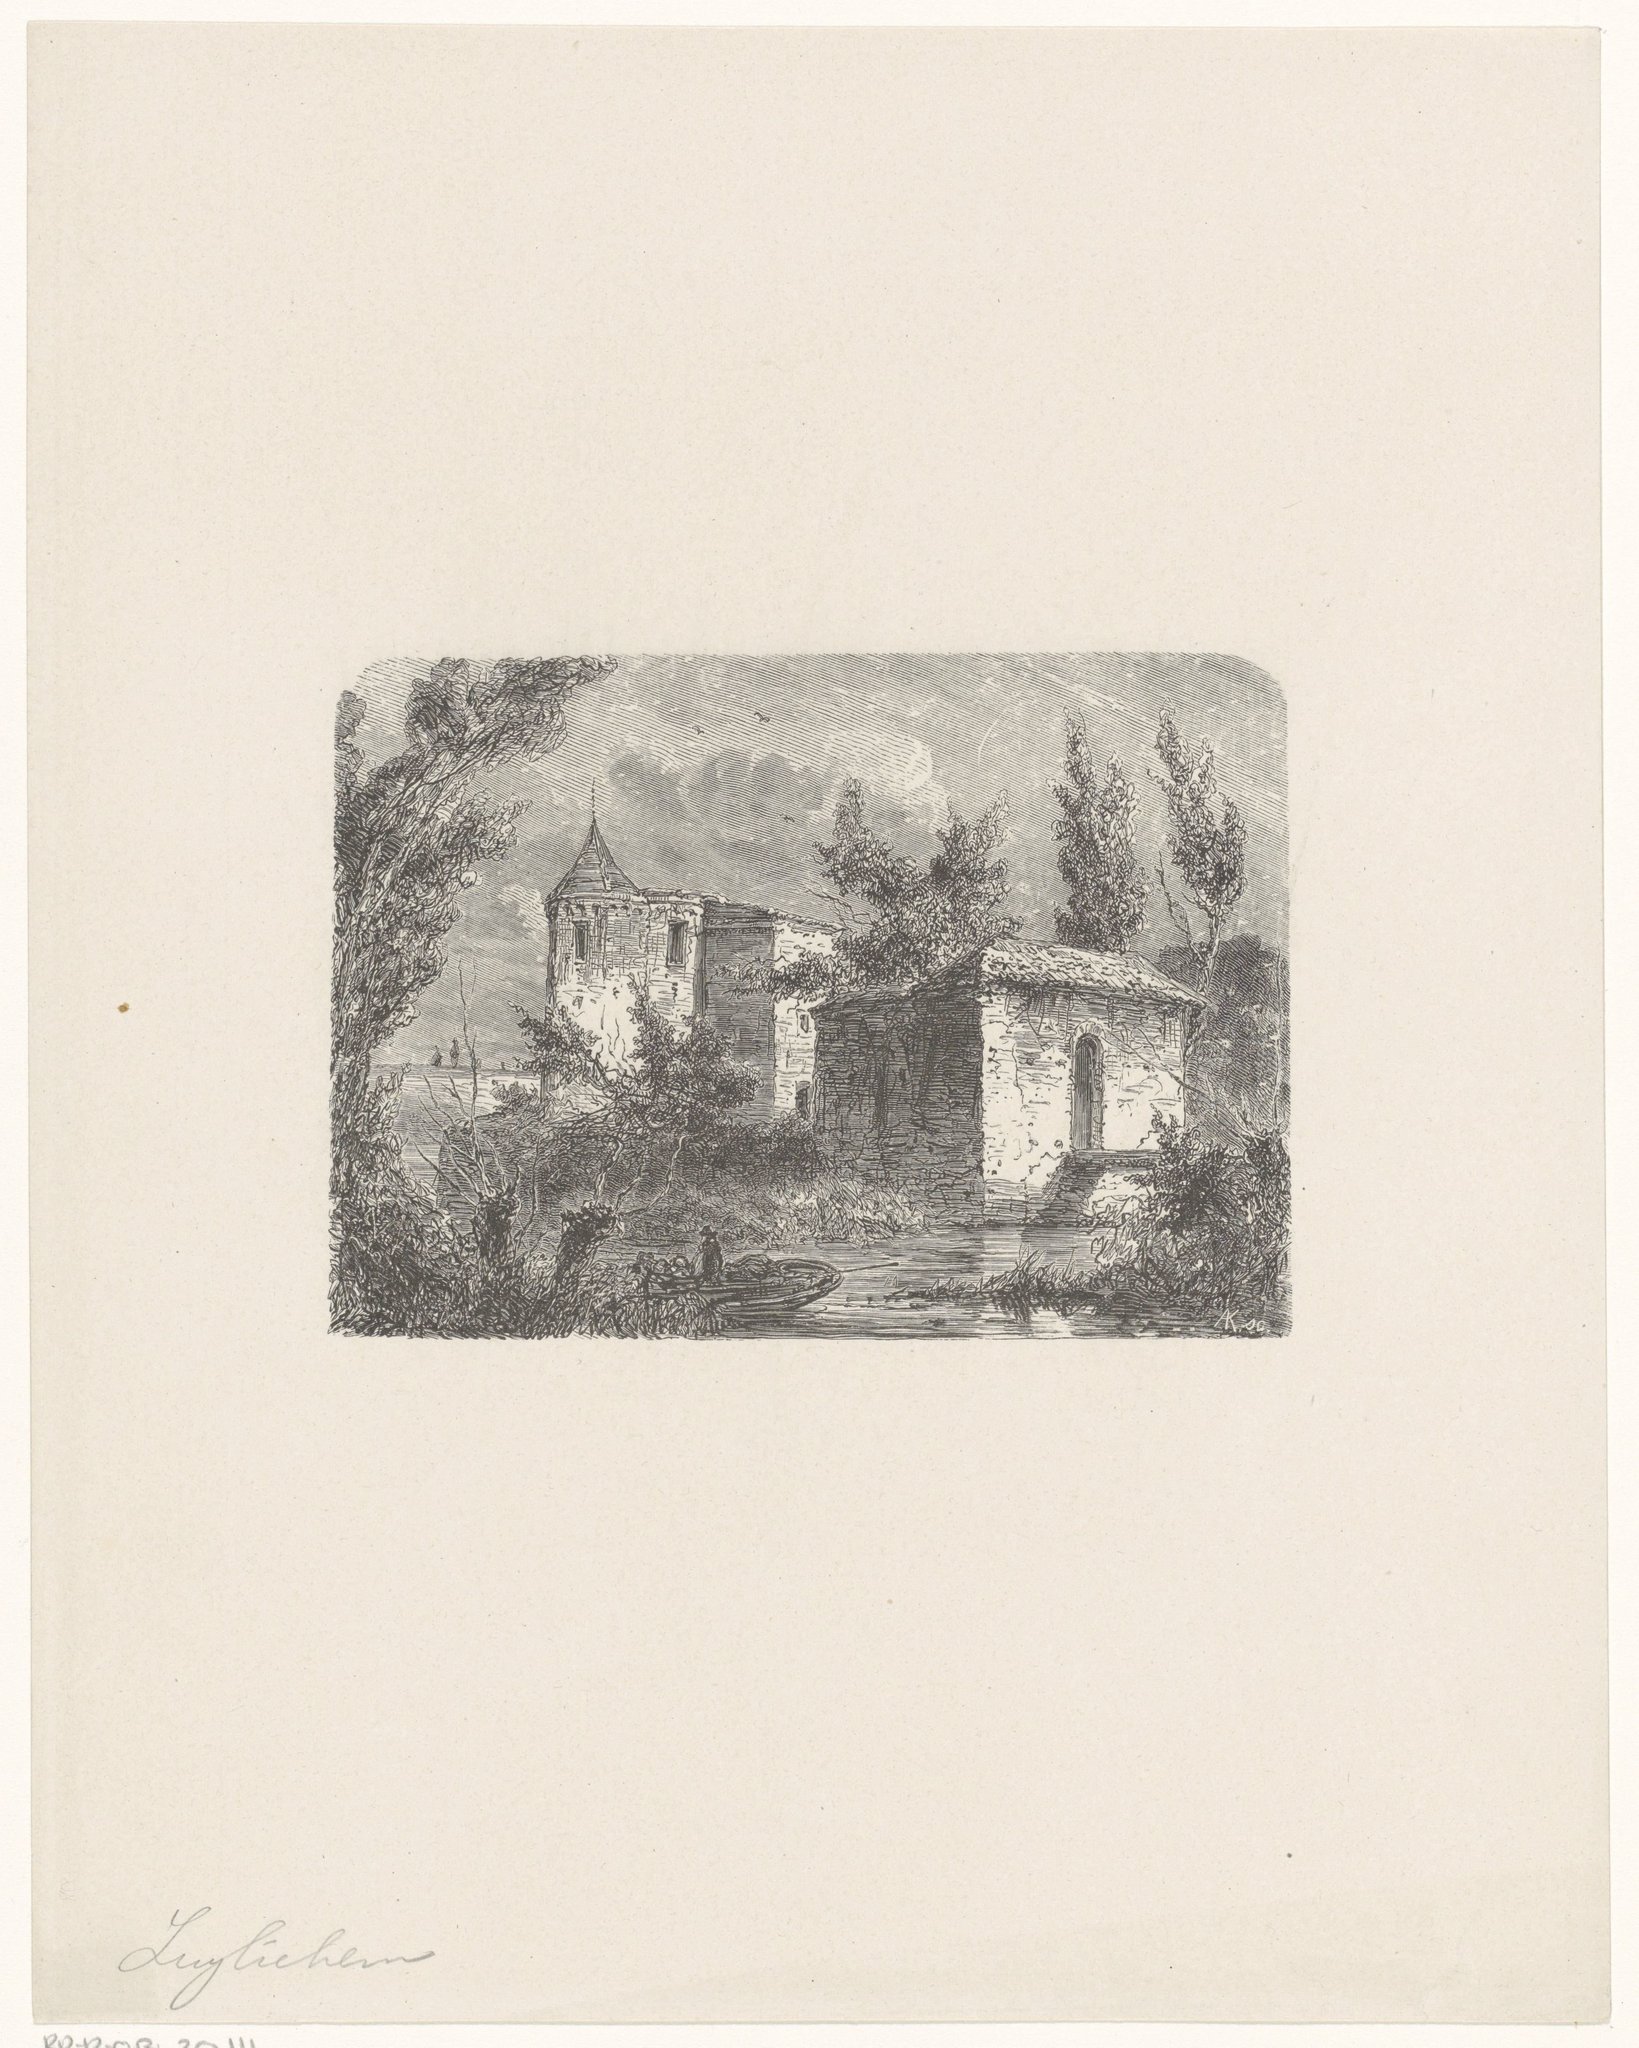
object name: print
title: Rivierlandschap met een kasteel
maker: a. kachel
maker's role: print maker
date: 1800-1899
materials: paper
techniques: engraving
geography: netherlands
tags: rowing-boat, canoe, etc., landscape with tower or castle, trees: willow, river (+ landscape with figures, staffage)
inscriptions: collector's mark: Lugt 2228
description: Op de voorgrond staan knotwilgen en staat een man in een boot.